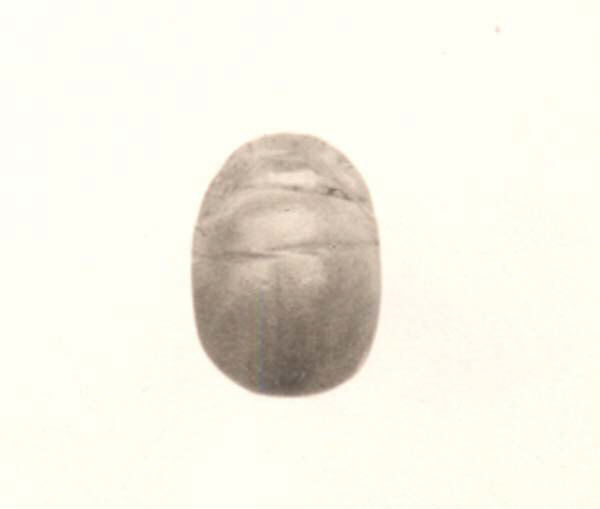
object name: stamp seal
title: Scarab seal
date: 700-501 BCE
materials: gemstone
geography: cyprus (?)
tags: scarabs